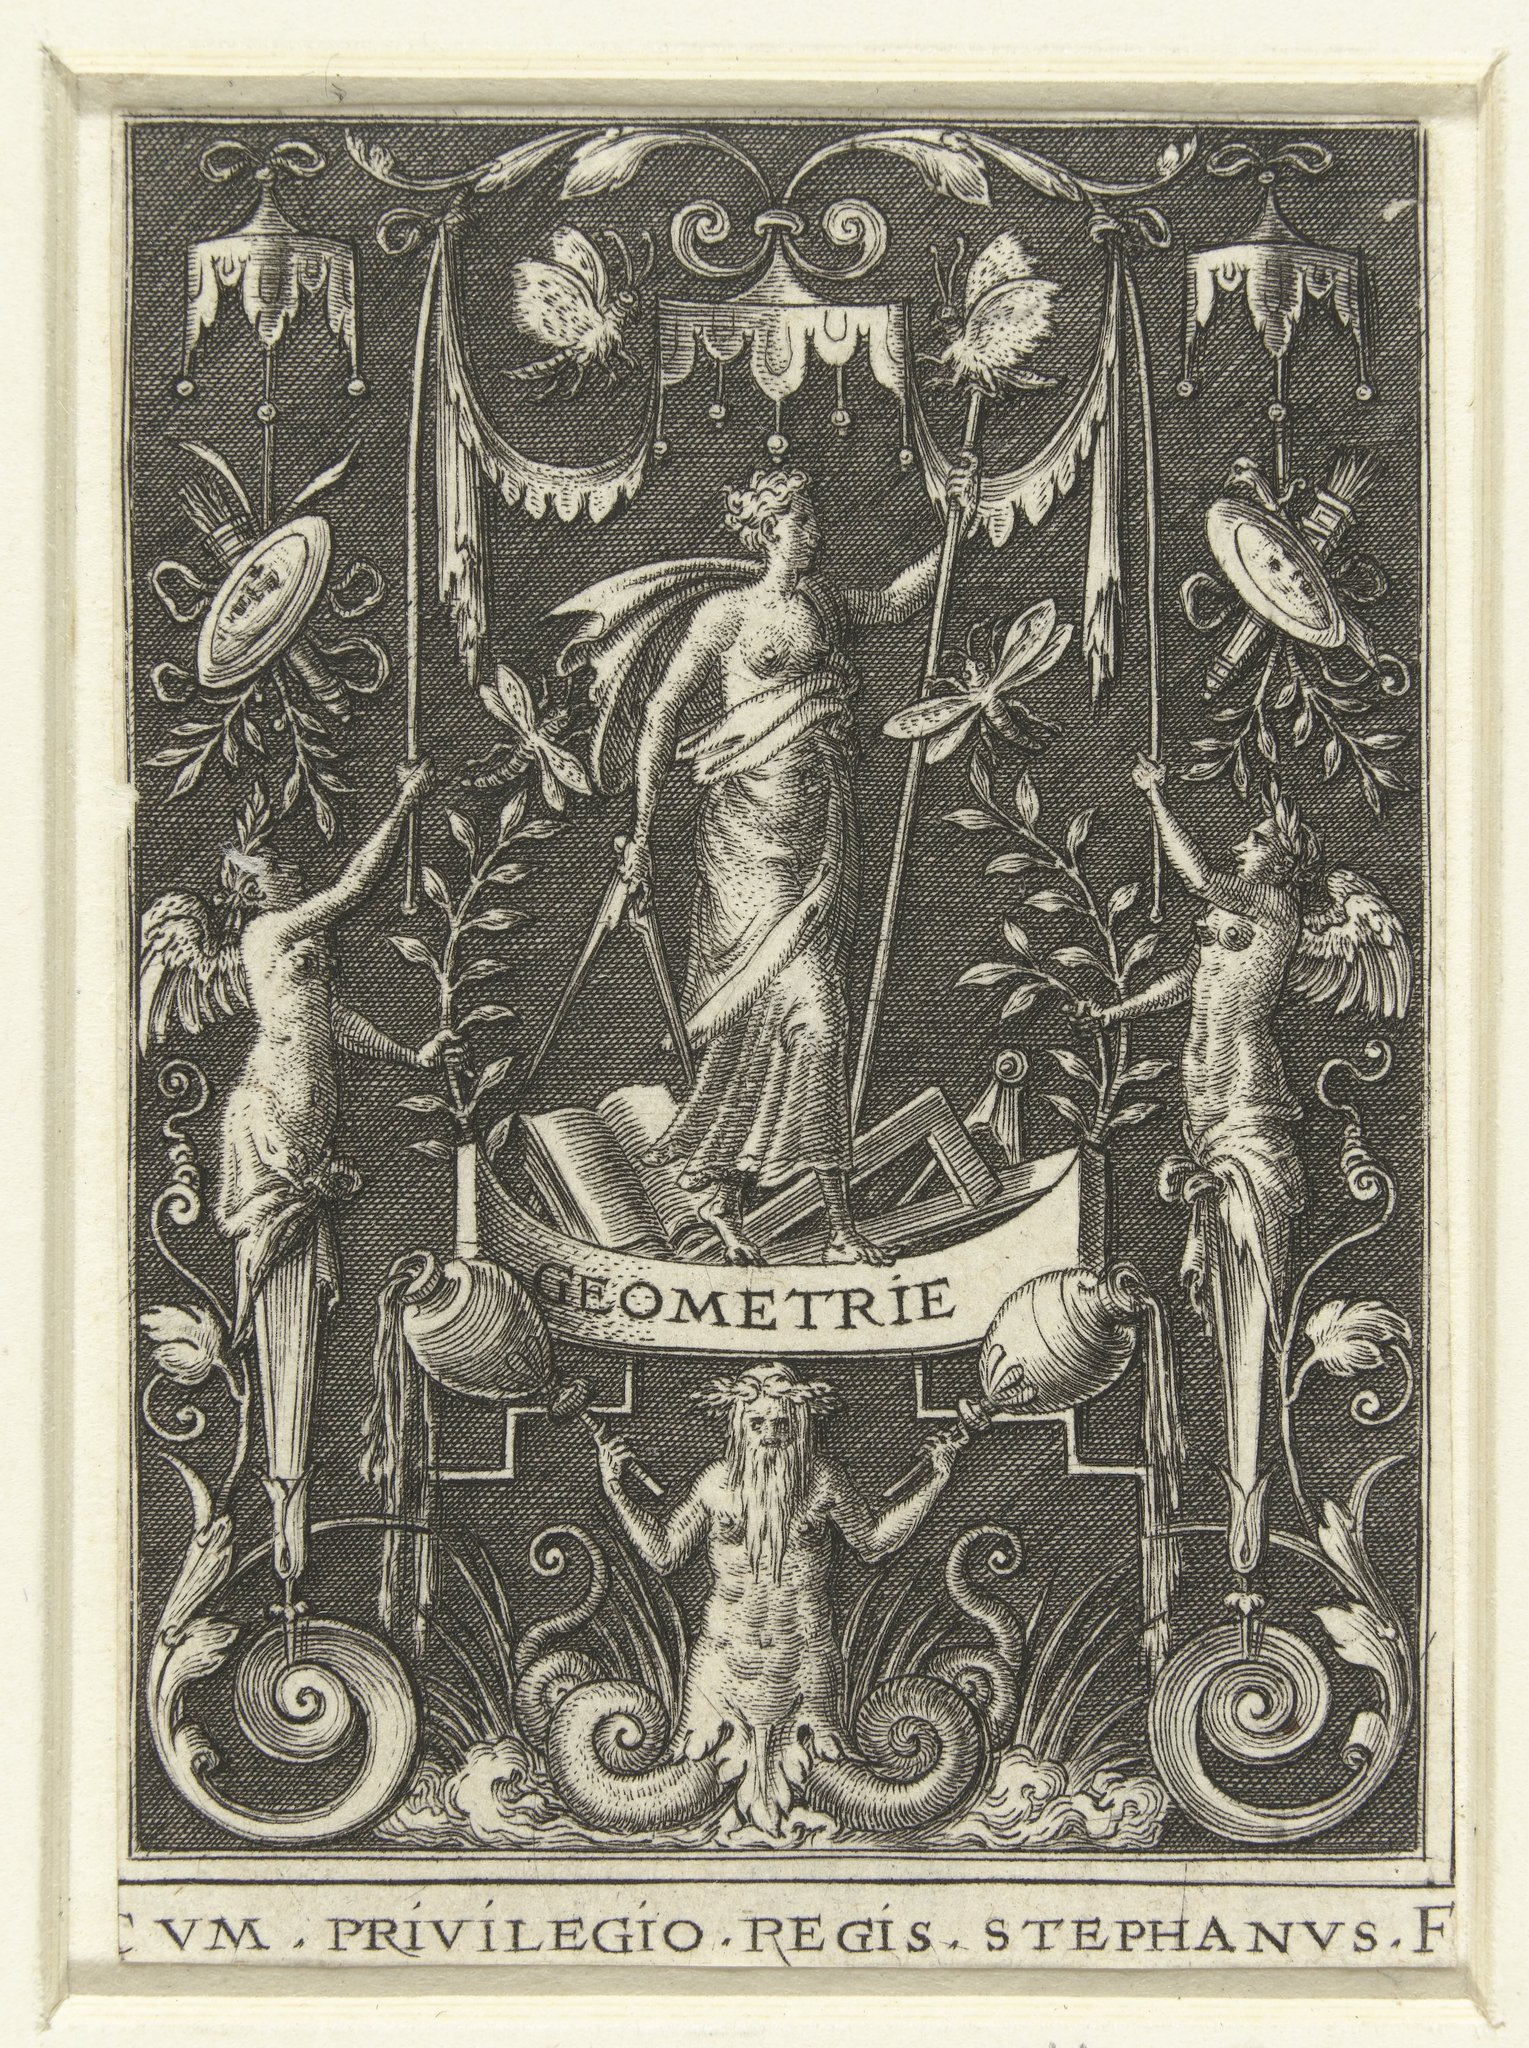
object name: ornament print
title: Vier Vrije Kunsten, het Perspectief en de Architectuur, voorgesteld door vrouwen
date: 1528-1583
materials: paper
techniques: engraving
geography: france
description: De Geometrie met een passer in de hand. Linksonder en rechtsonder staat een gevleugelde vrouwelijke herme. Prent uit de reeks van 6 bladen uit der Wetenschappen en Vrije Kunsten.